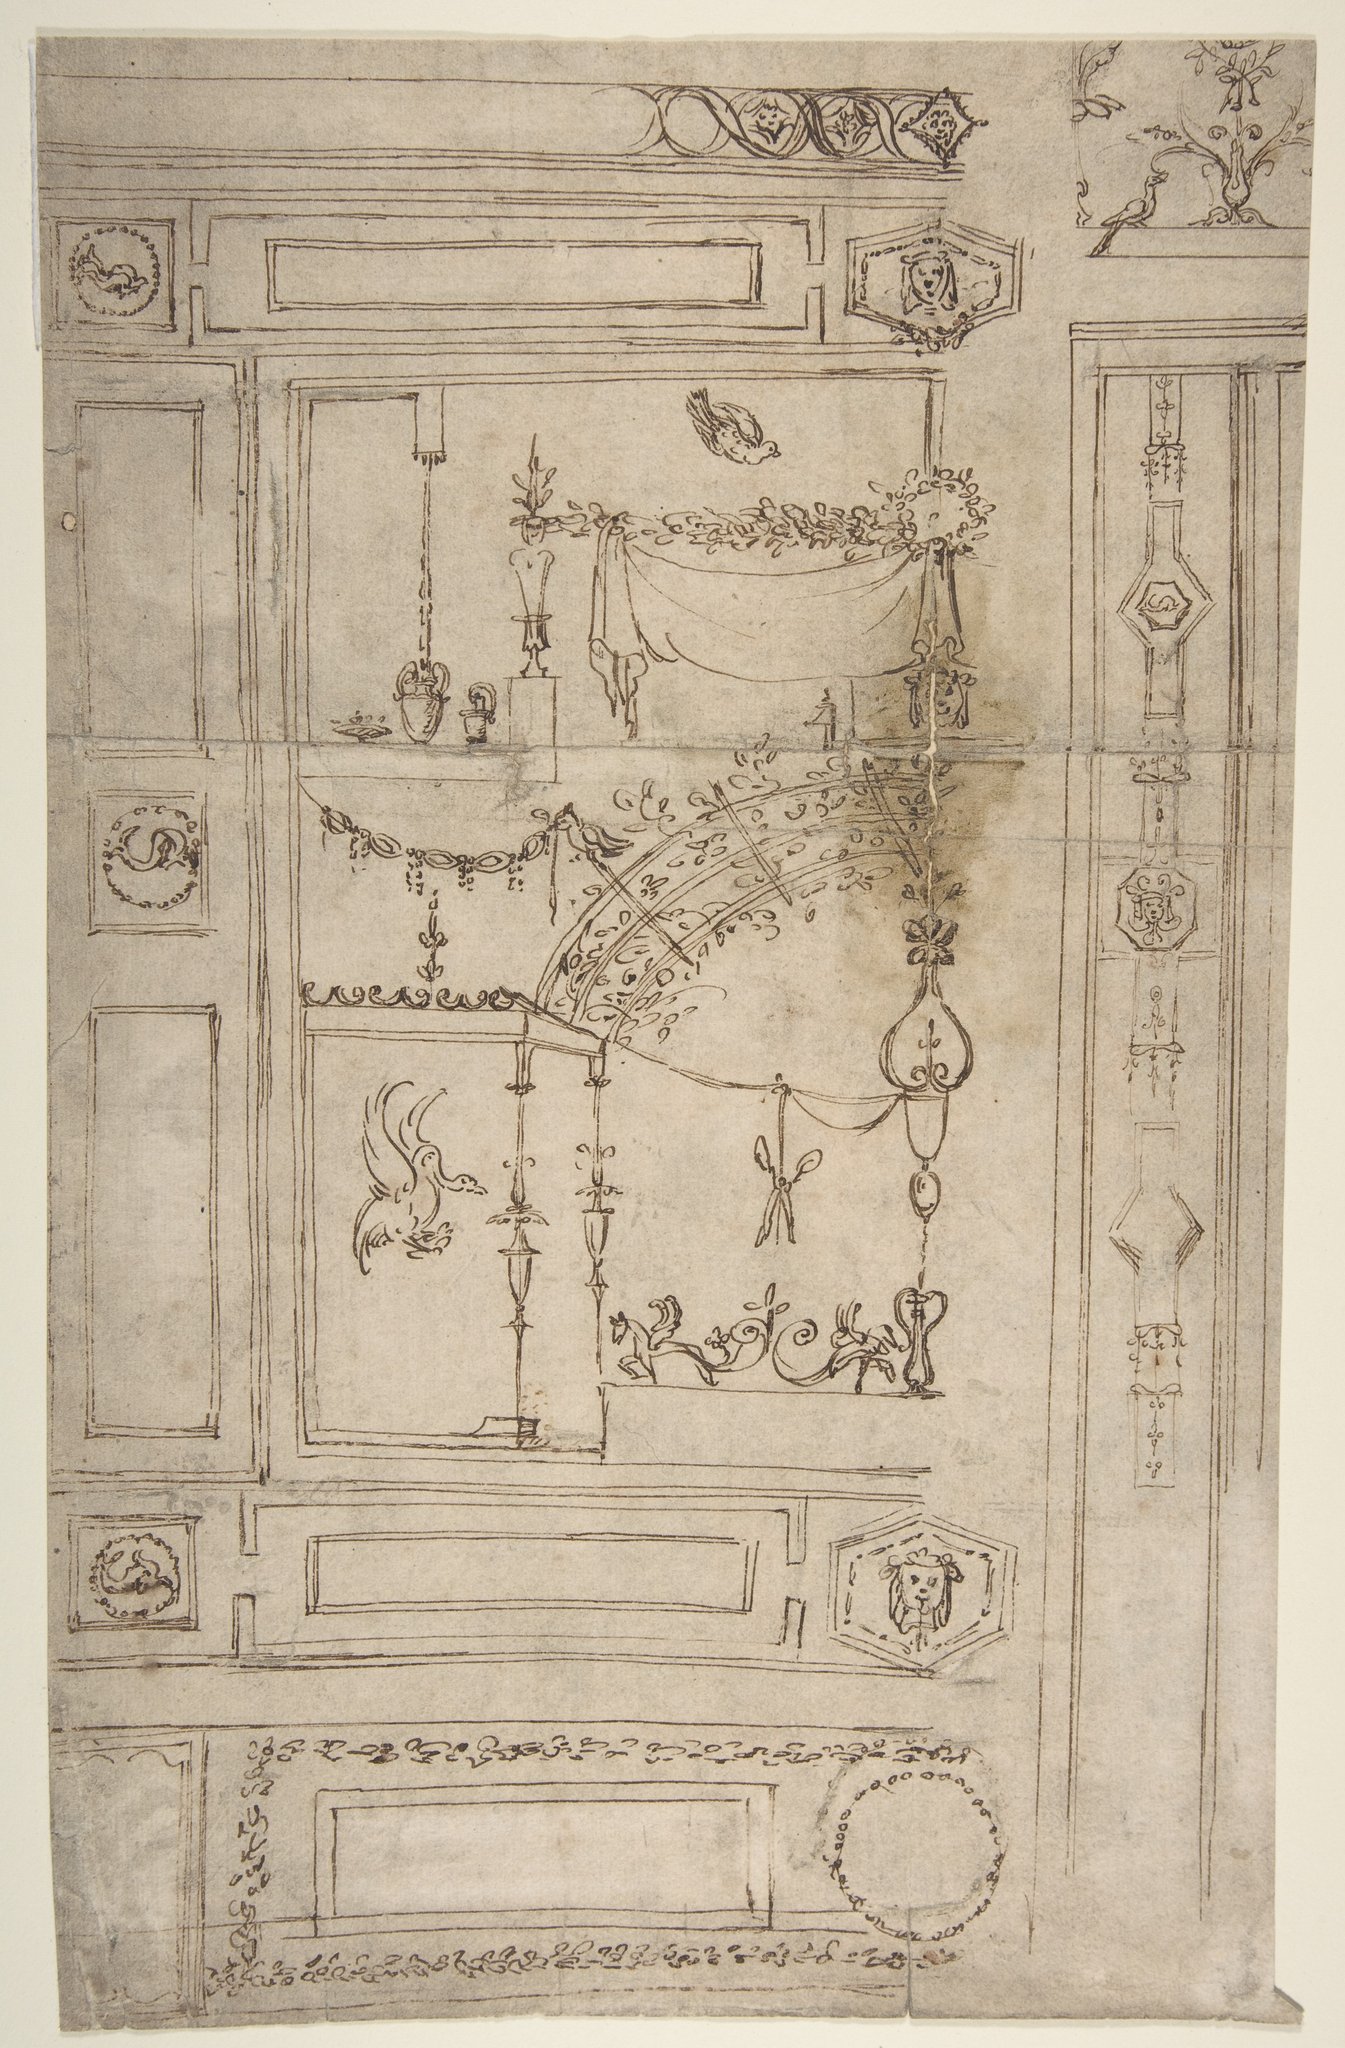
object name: drawing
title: Design for Grotesque Wall Decoration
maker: perino del vaga (pietro buonaccorsi)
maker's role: artist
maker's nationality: italian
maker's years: 1501-1547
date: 1501-1533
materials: ink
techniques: pen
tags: birds,grotesques,ornament